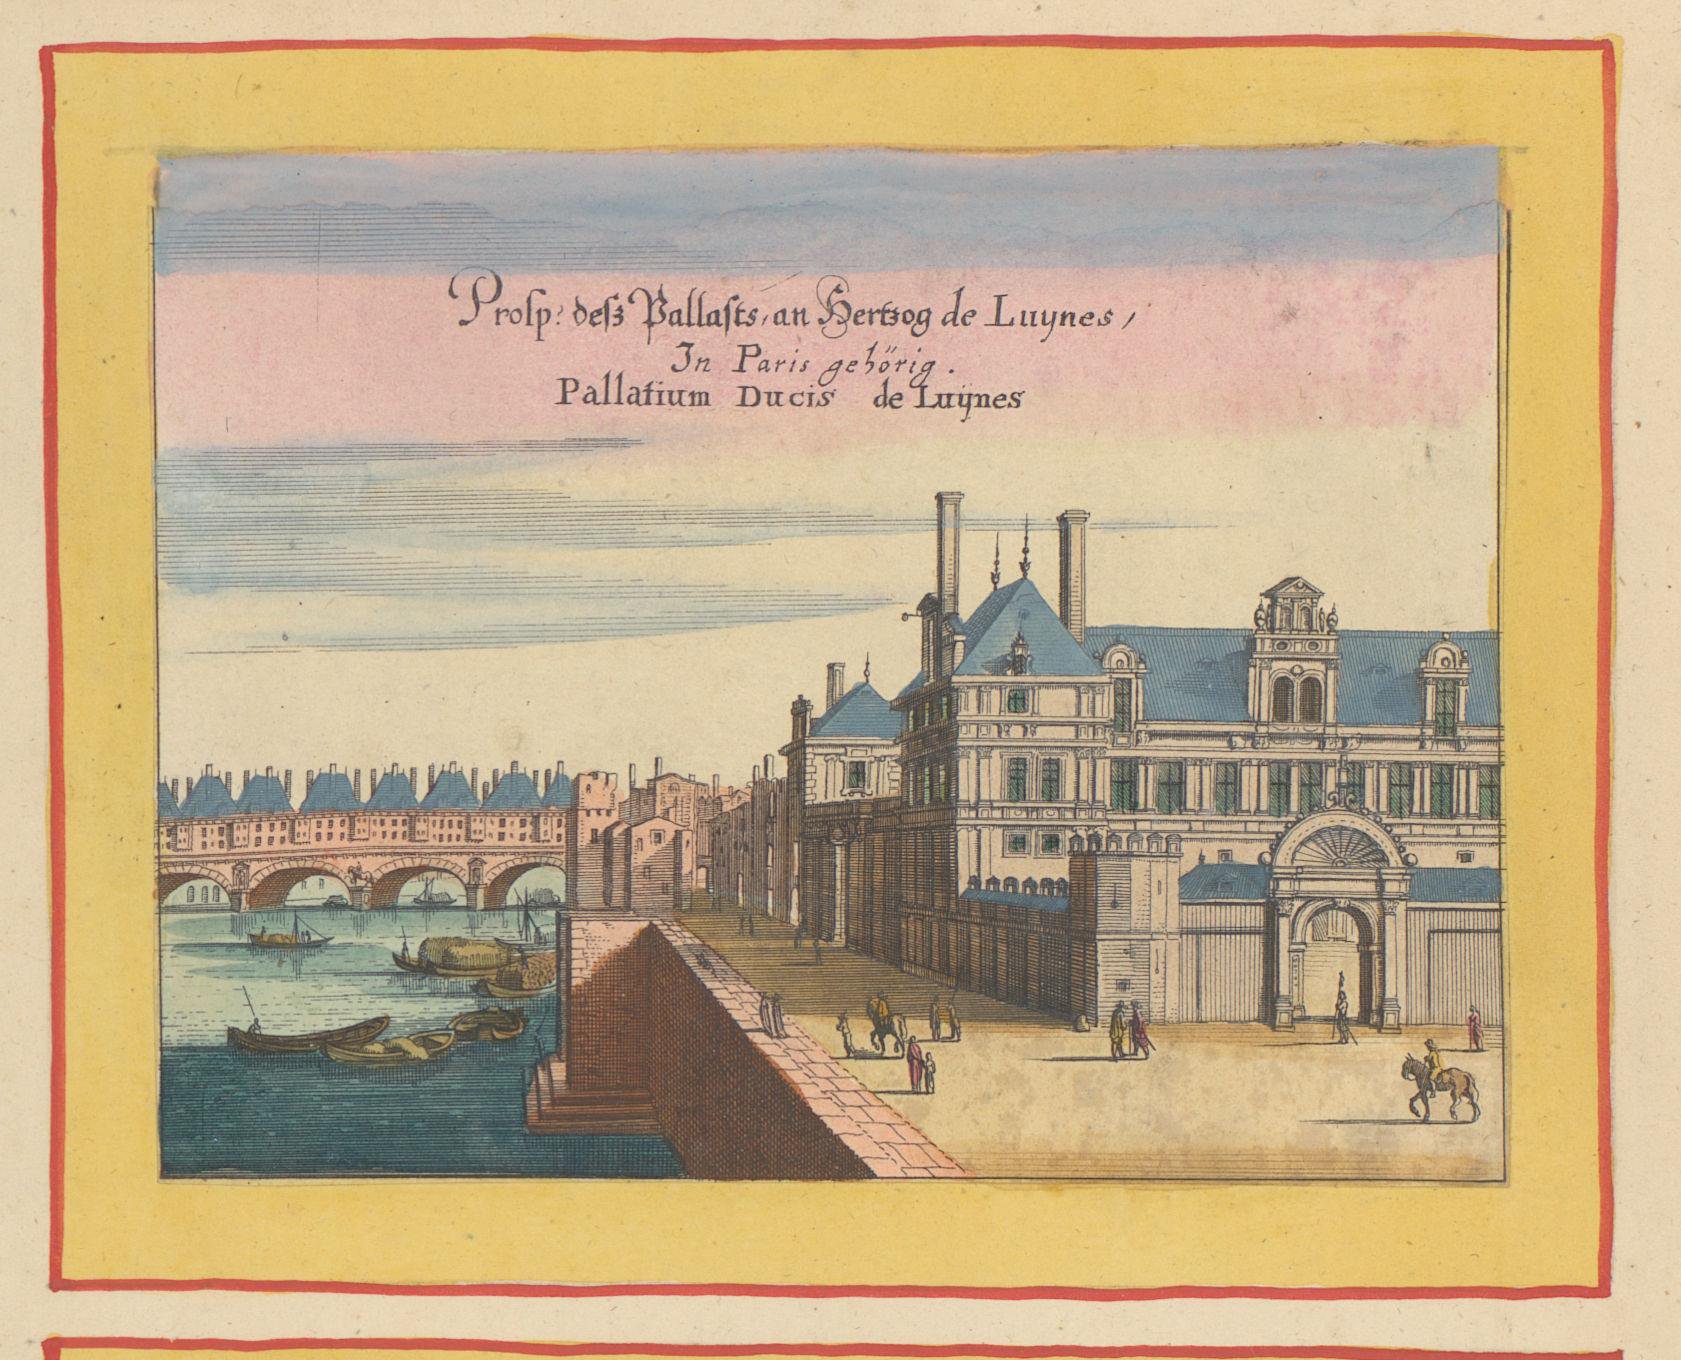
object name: album leaf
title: Gezicht op paleis van de hertog de Luynes te Parijs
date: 1655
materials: paper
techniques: engraving, etching, hand coloring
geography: the hague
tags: hôtel, i.e. small palace in city, paris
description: Prent origineel vervaardigd als boekillustratie voor: Zeiller, Martin. Topographia Galliae, oder Beschreibung und Contrafaitung der vornehmbsten und bekantisten Oerter in dem mächtigen und grossen Königreich Frankreich, 13 delen. Frankfurt am Main: Caspar Merian, 1655-1661. De prent werd voor het eerst gepubliceerd in deel 1: Topographia Galliae, 1655. De prent is langs de bovenrand van de voorstelling afgescheurd. De voorstelling is aan de bovenzijde aangevuld met een geschilderde lucht.